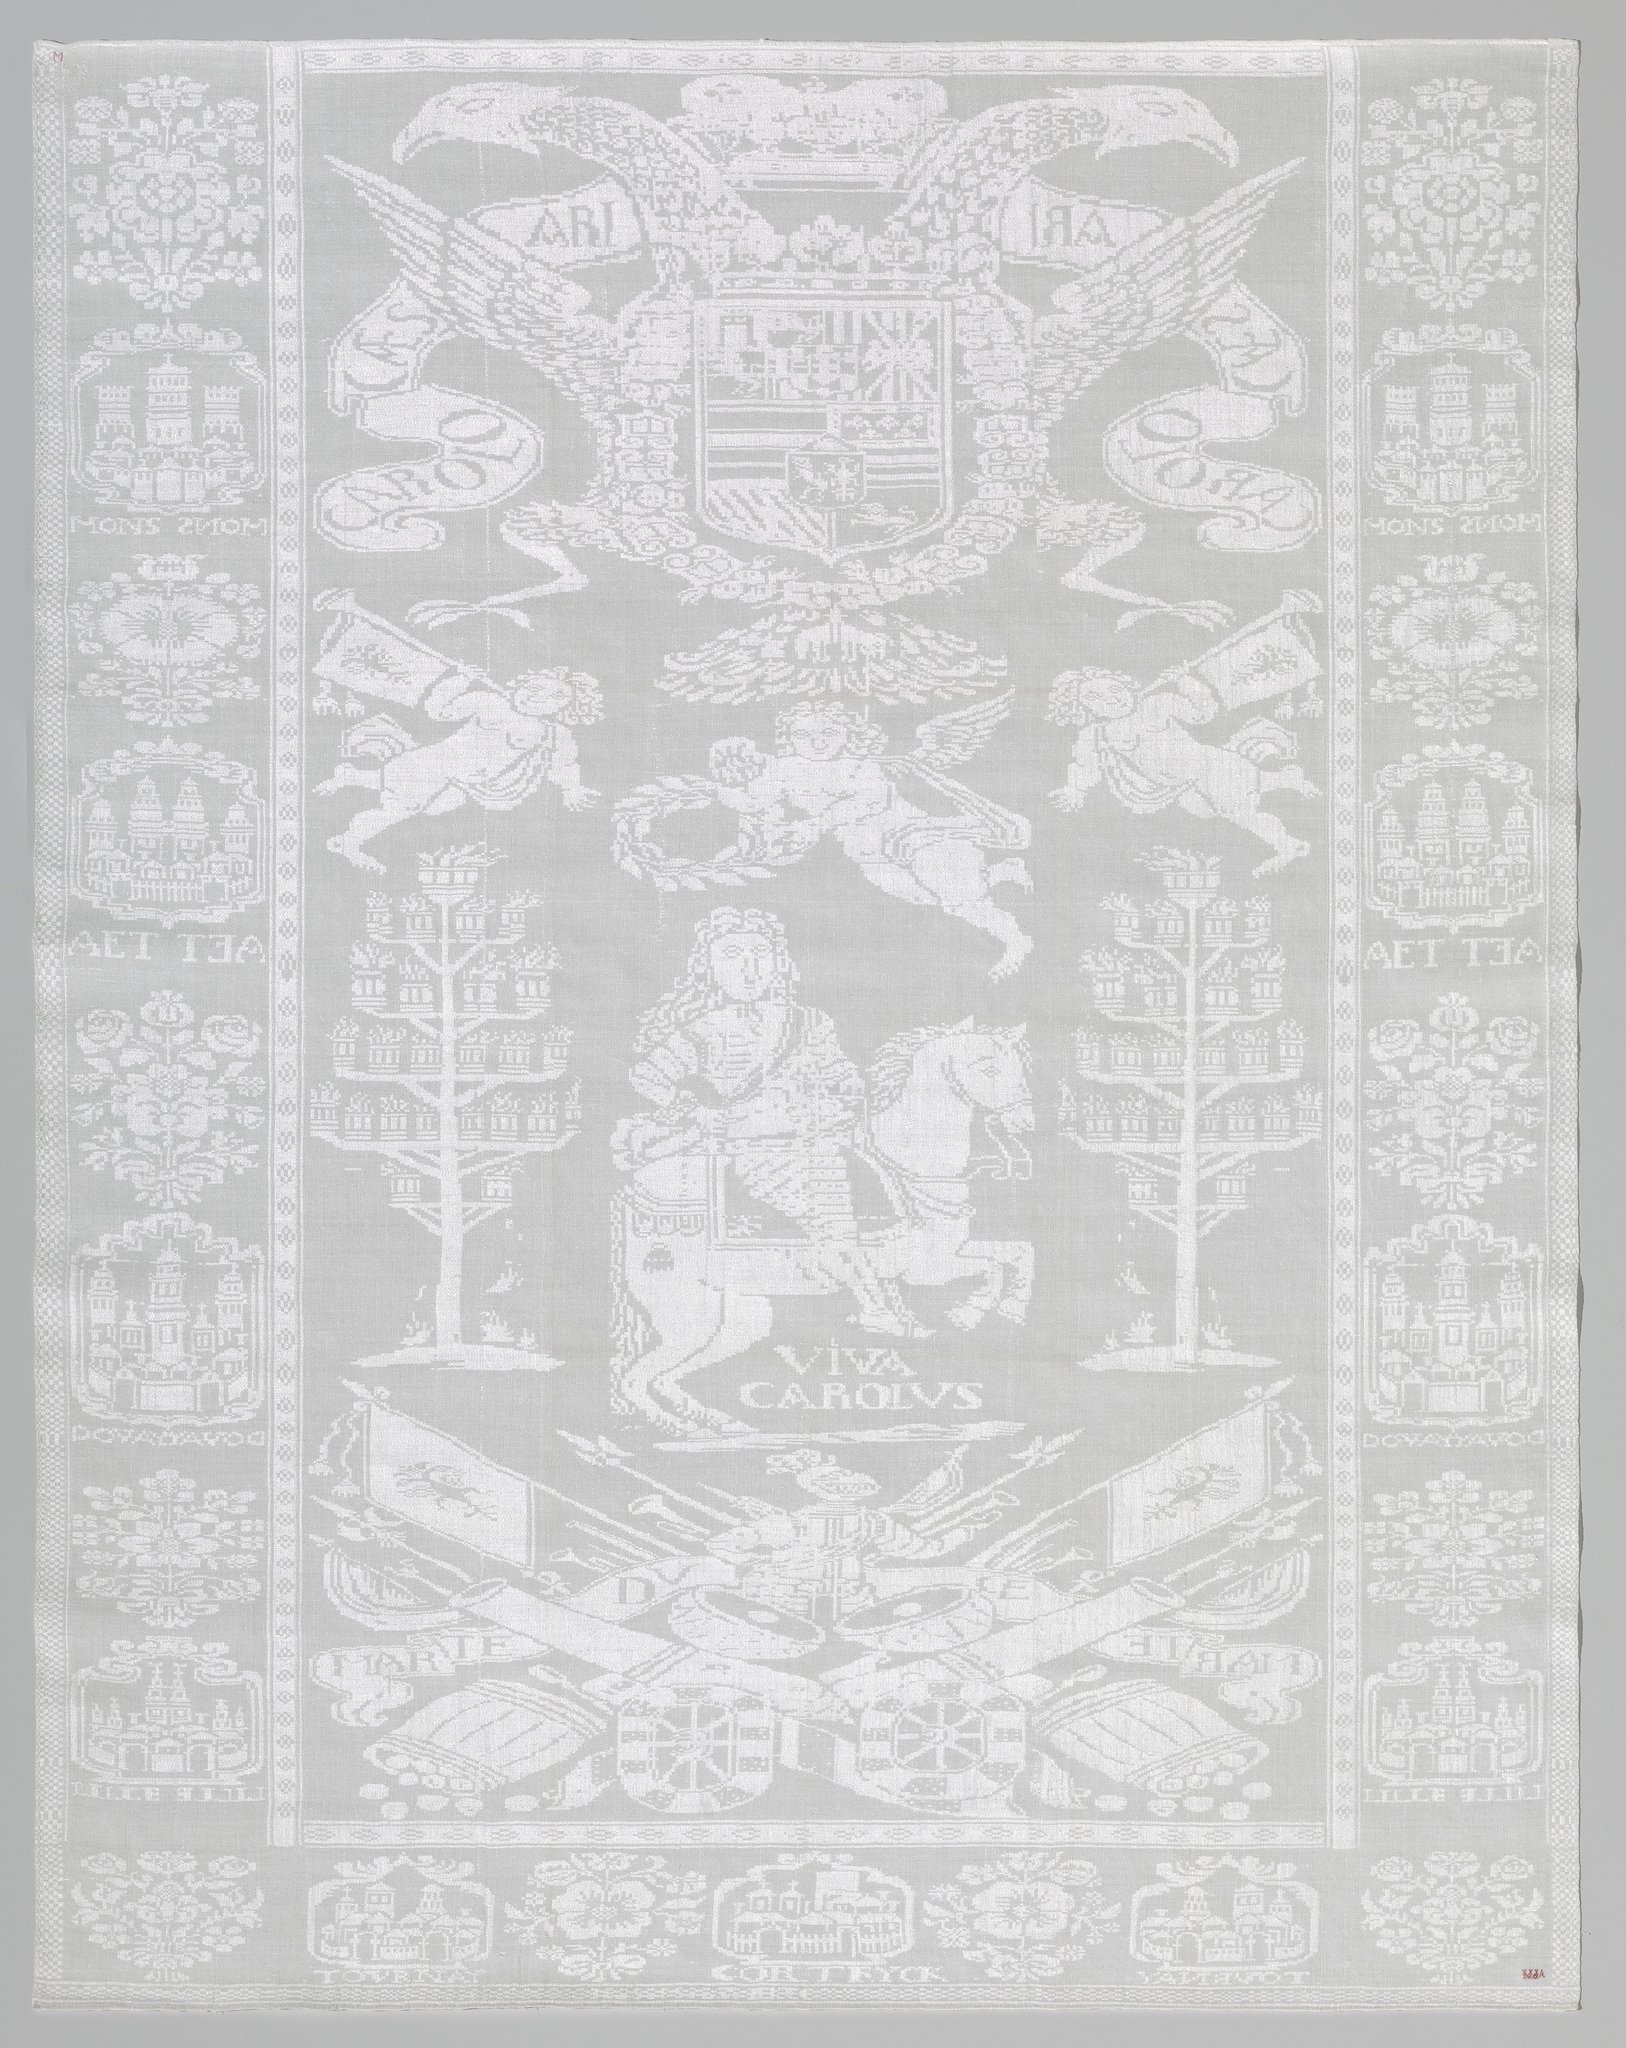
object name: napkin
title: Servet van linnendamast met Karel VI van Habsburg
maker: Anonymous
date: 1711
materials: linen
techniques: damask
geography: flanders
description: Wit linnen damasten servet met de verheerlijking van Karel VI van Habsburg als keizer van het Heilige Roomse Rijk. Gemerkt met bindgatletters "CSP 13", met rode steelsteek "M", en rode kruissteek "v P N".